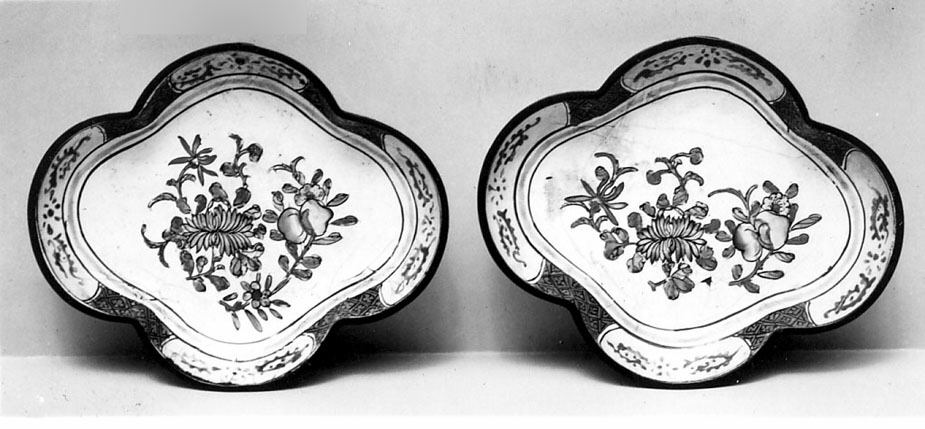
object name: tray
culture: chinese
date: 1801-1900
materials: enamel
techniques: painting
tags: flowers